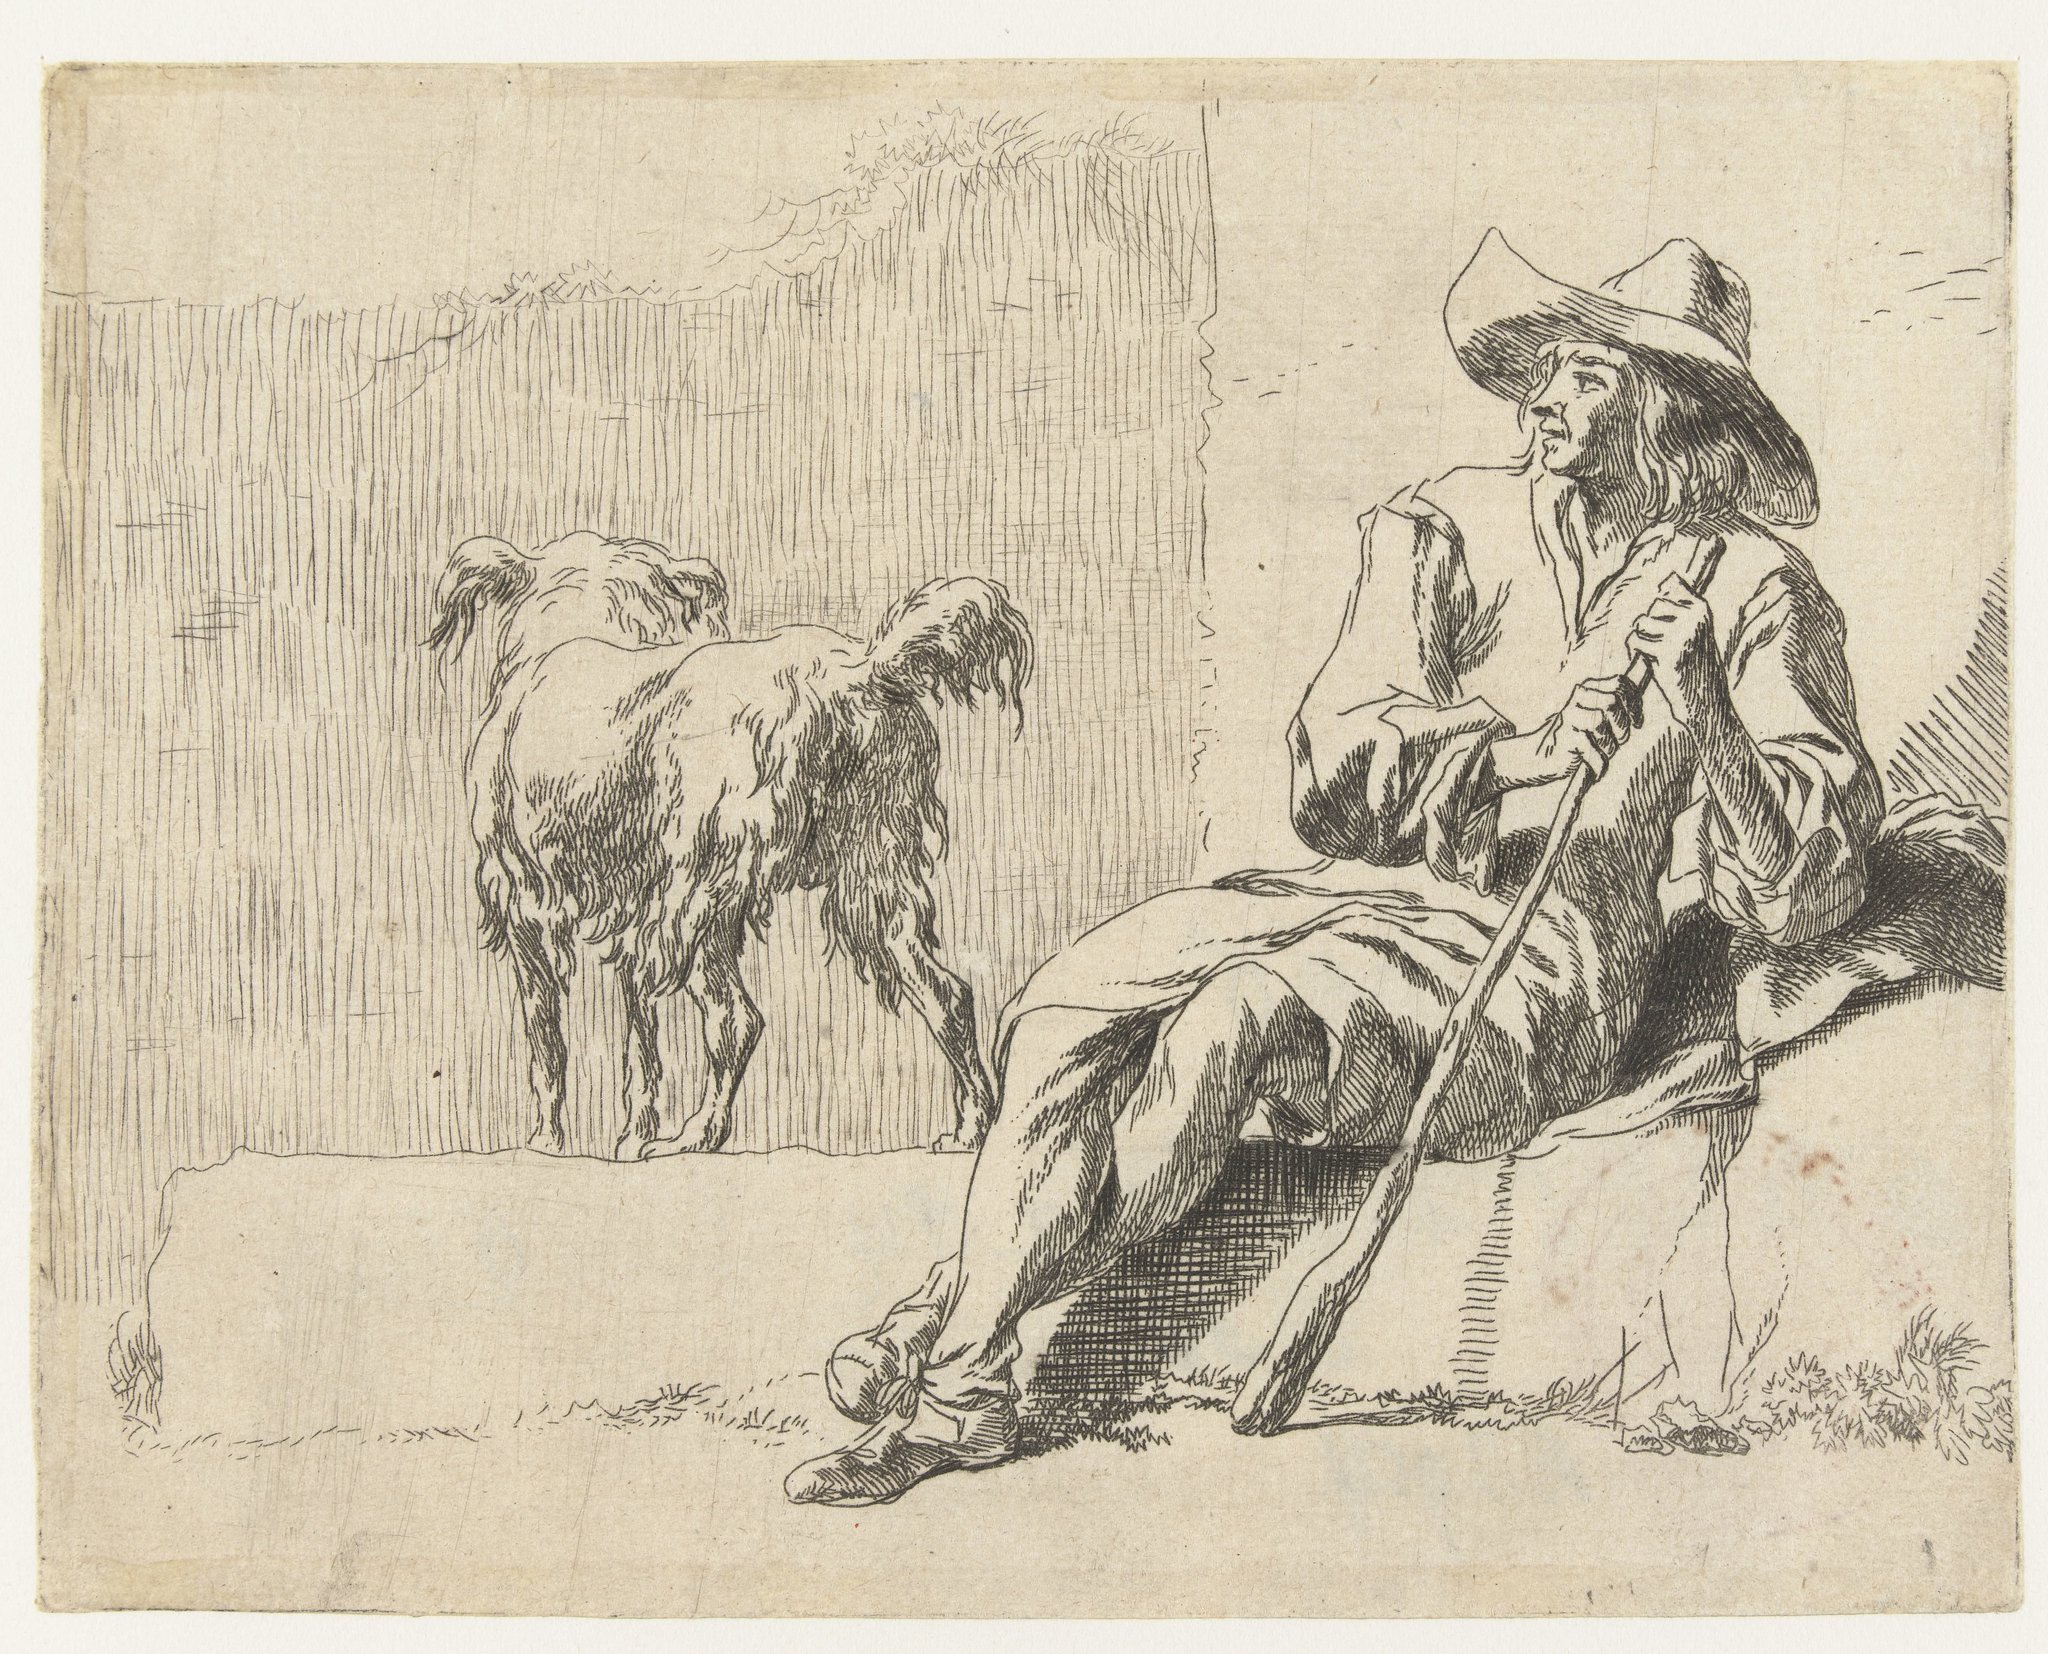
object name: print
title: Geiten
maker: nicolaes pietersz berchem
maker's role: draughtsman, print maker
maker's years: 1620-1683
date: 1648-1652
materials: paper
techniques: etching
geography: netherlands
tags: herding, herdsman, herdswoman, shepherd, shepherdess, cowherd, etc., dog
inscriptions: collector's mark: Lugt 240